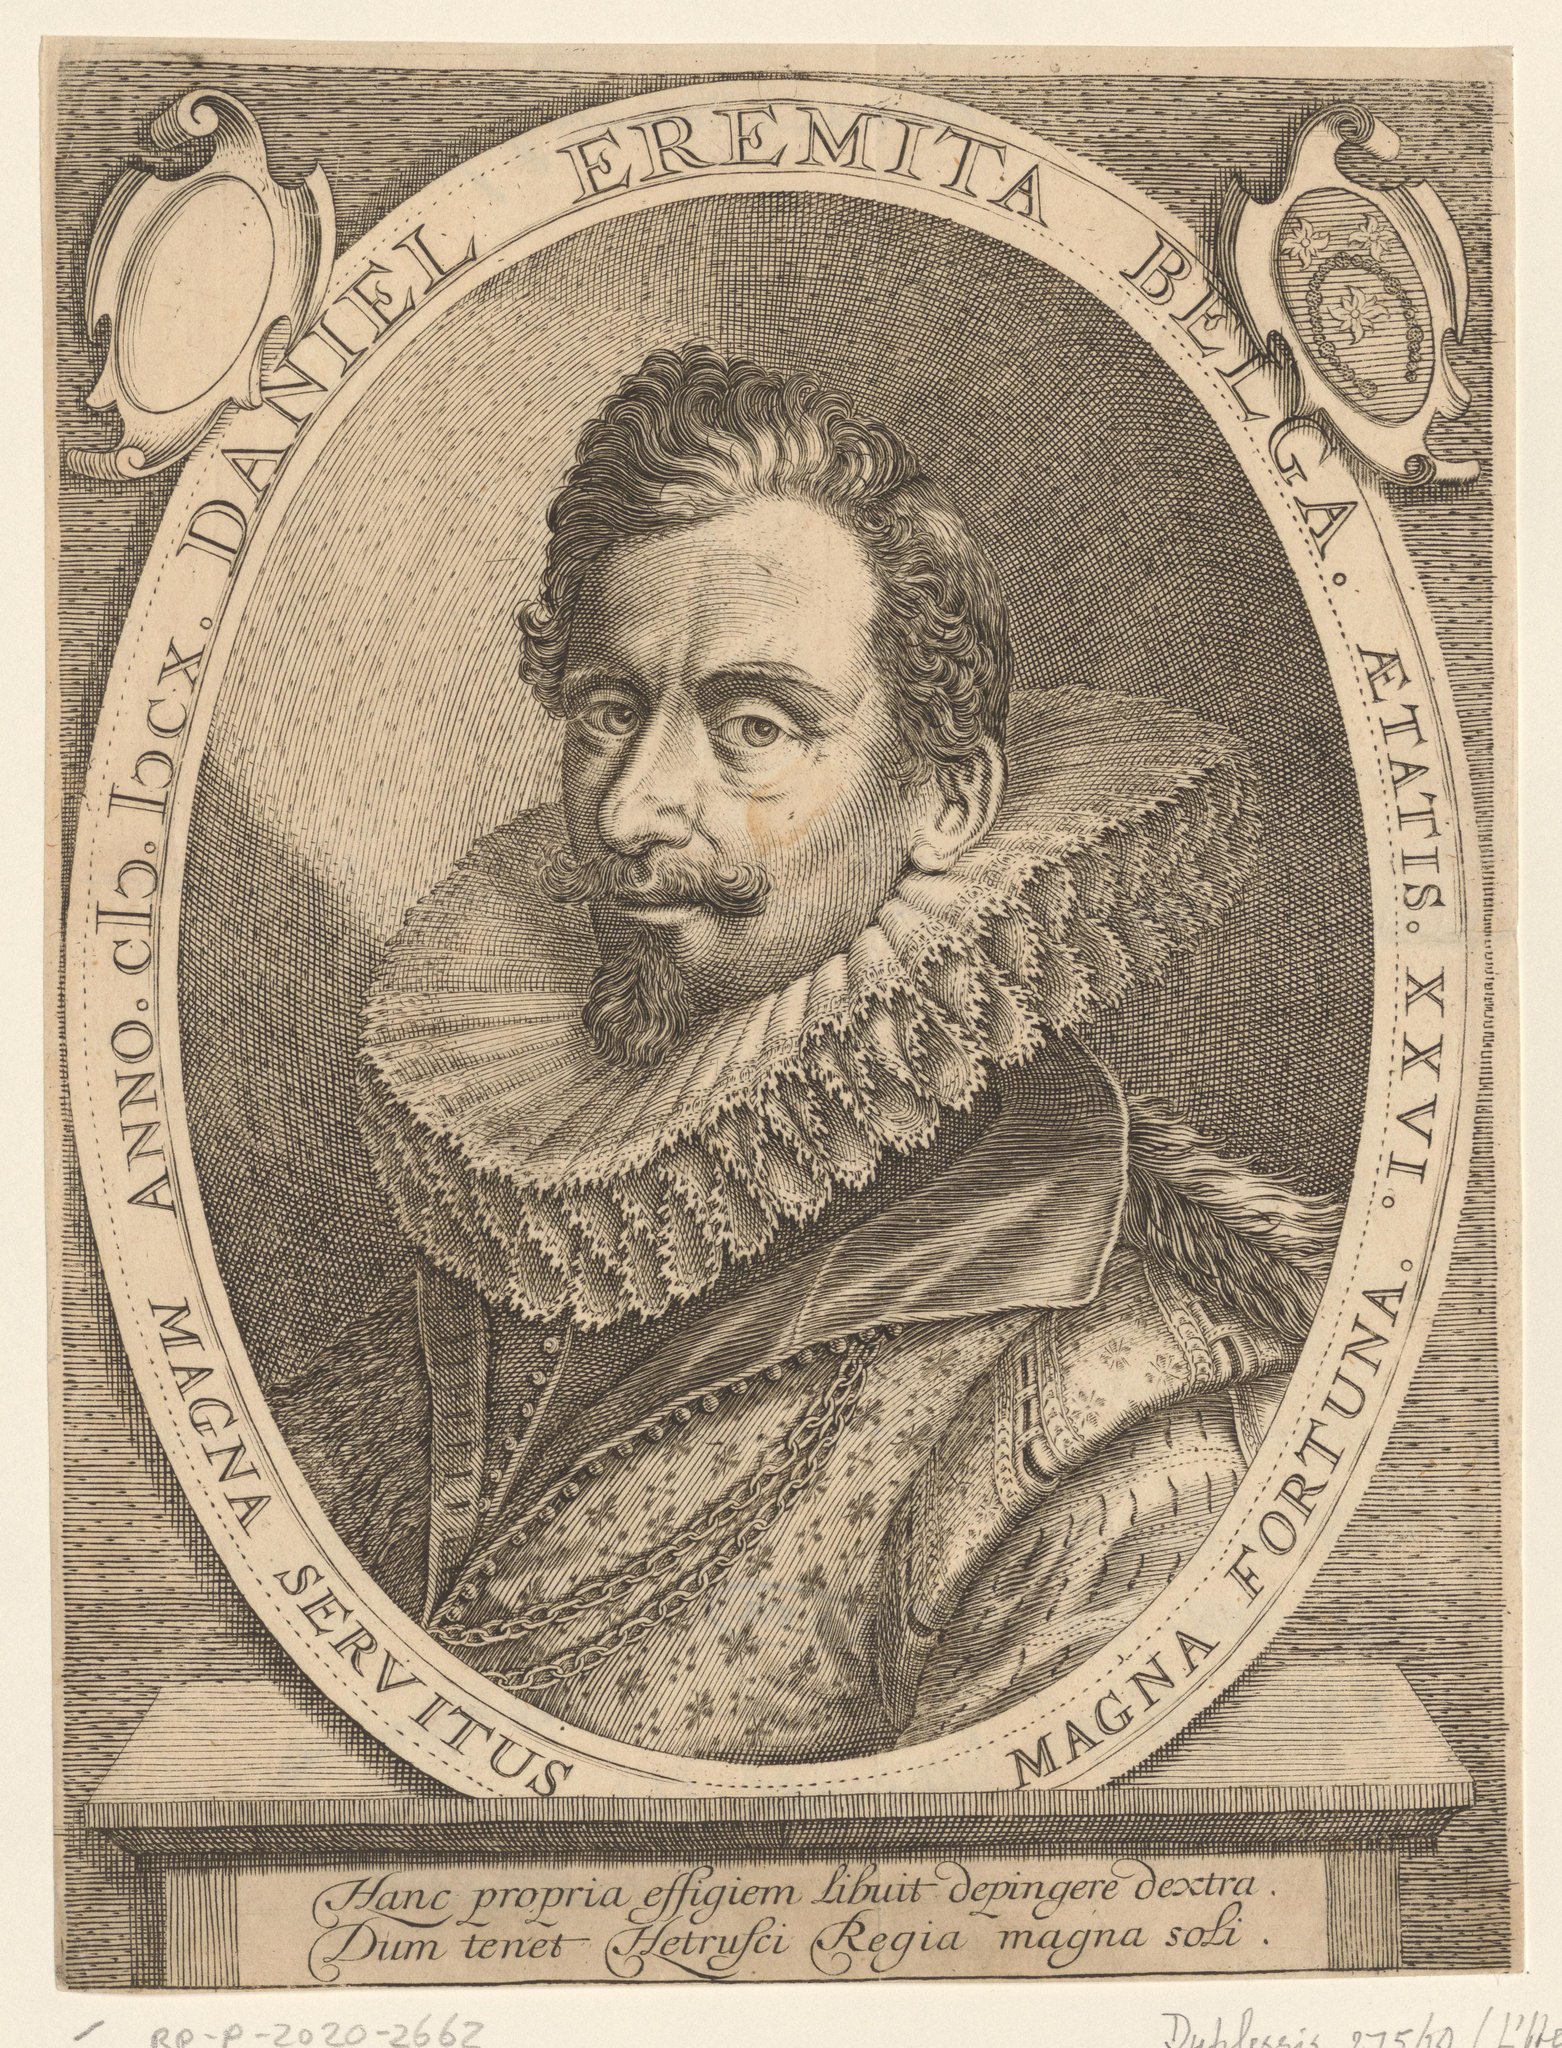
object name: print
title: Portret van Daniel Eremita op 26-jarige leeftijd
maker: jacob matham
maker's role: draughtsman, print maker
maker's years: 1571-1631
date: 1610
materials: paper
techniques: engraving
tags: antwerp, draughtsman, daniel eremita, historical persons, armorial bearing, heraldry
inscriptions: collector's mark: Lugt 2228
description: Met tweeregelig onderschrift in het Latijn.